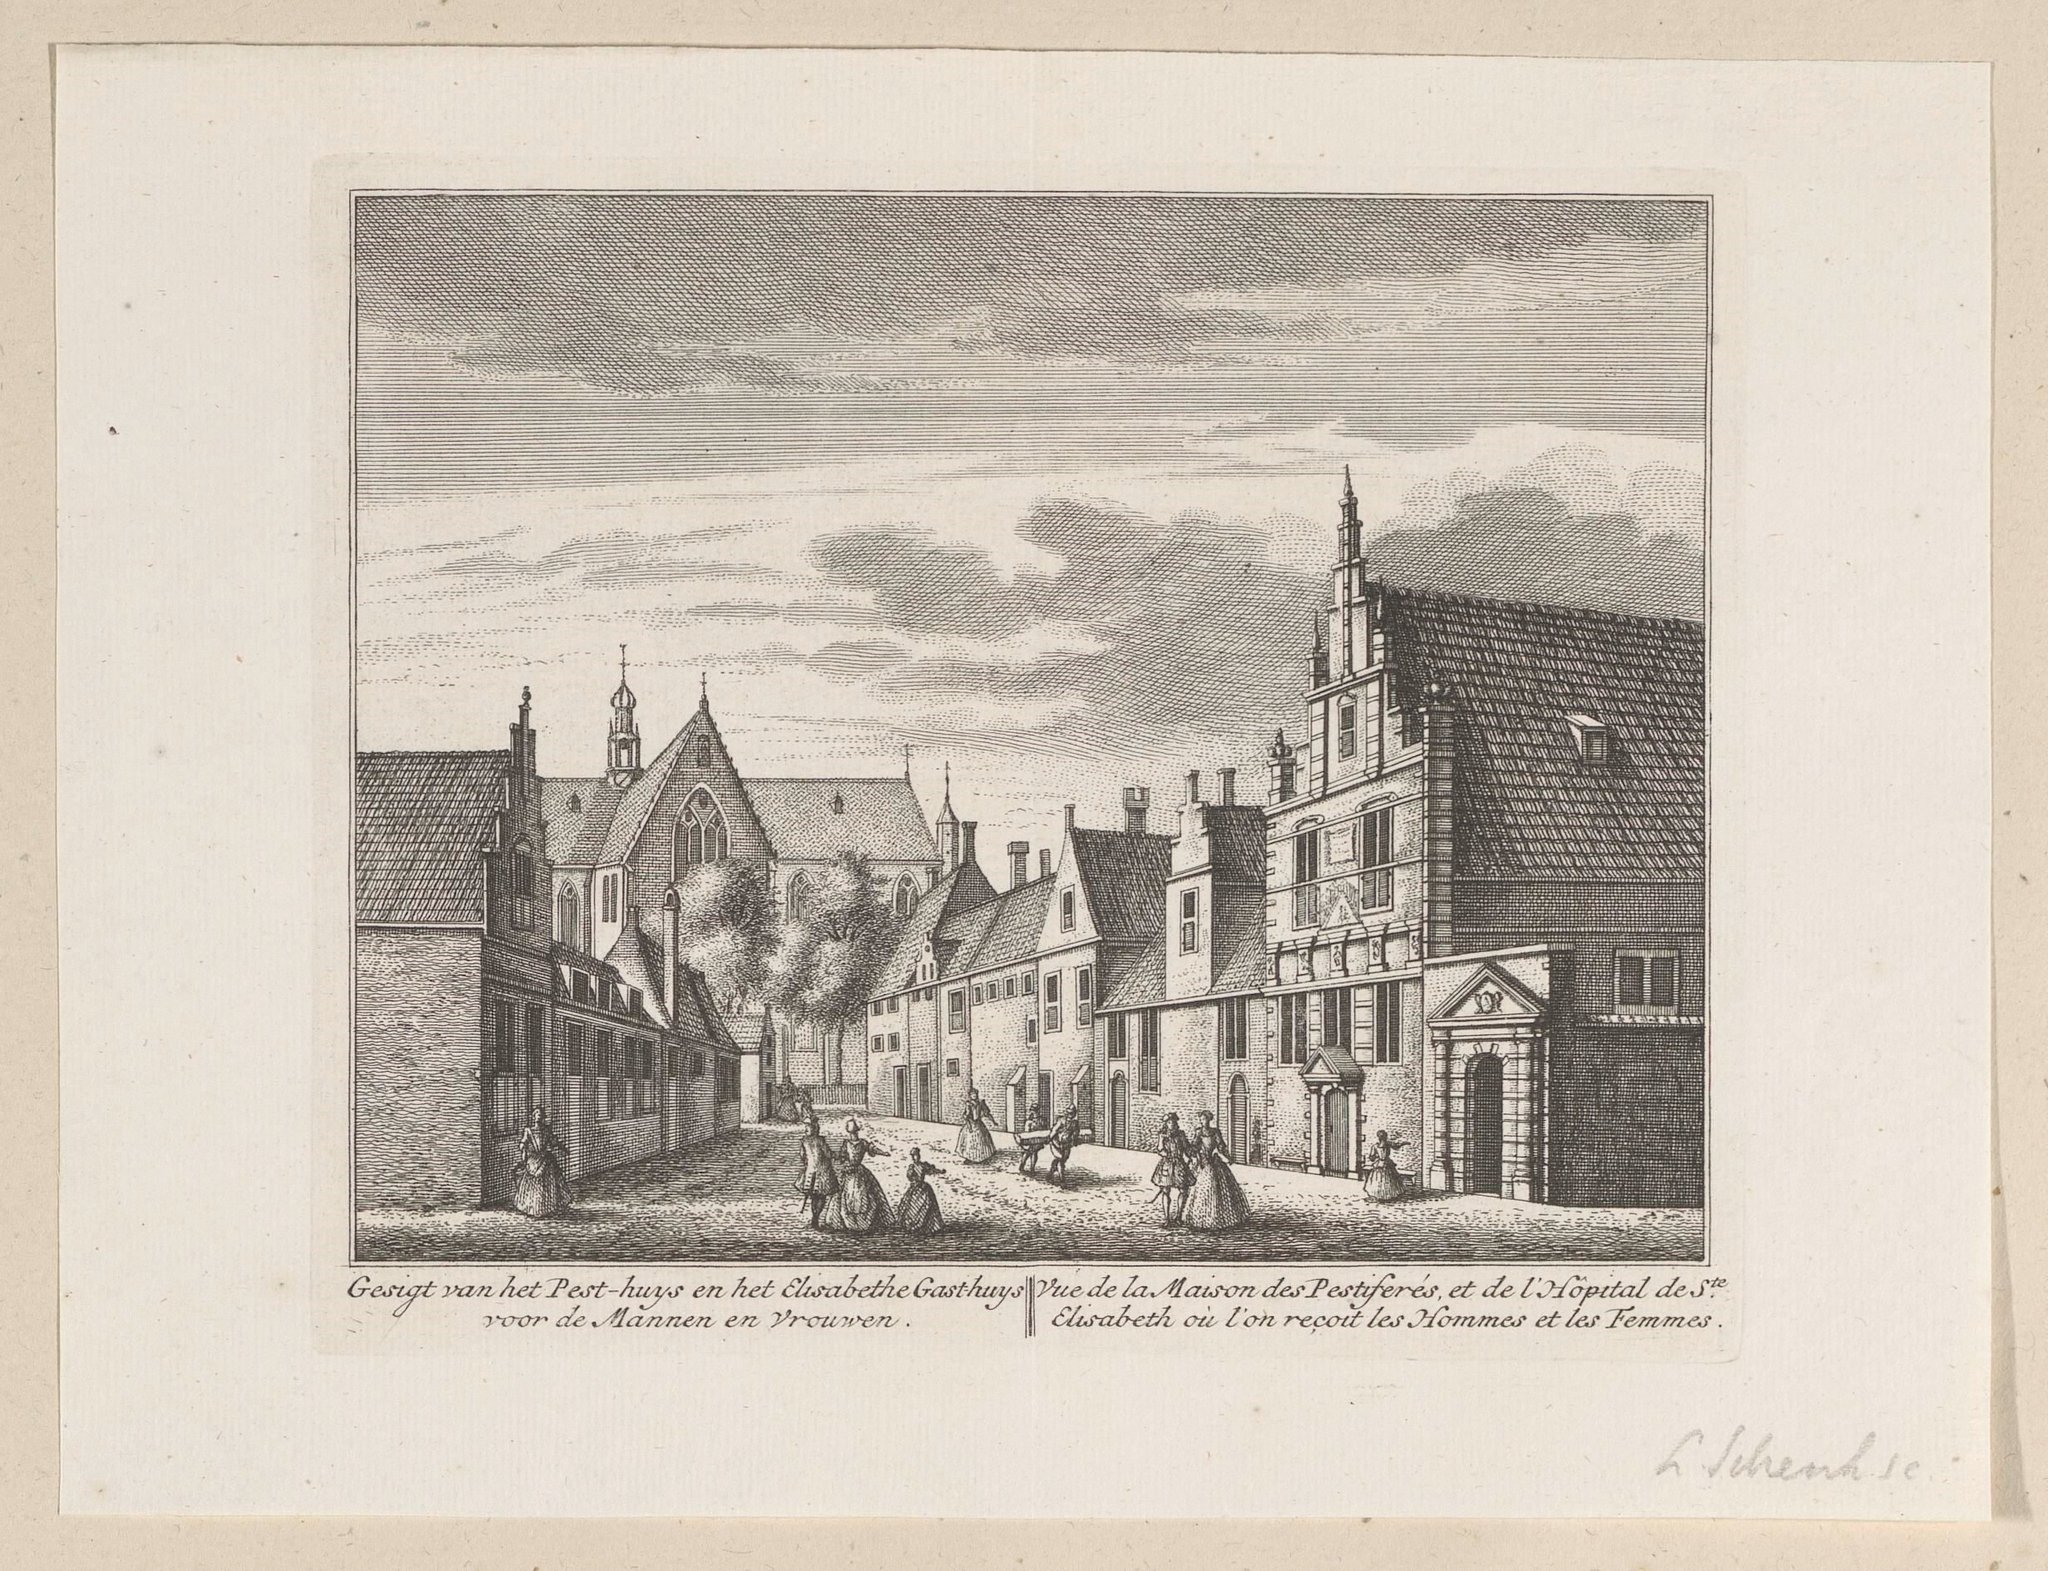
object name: print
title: Alle de voornaamste gesigten van de stadt Alckmaar geleegen in West-Vriesland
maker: leonard schenk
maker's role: print maker, publisher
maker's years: 1696-1767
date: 1736-1746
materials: paper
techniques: etching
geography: amsterdam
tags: hospital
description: Als onderdeel van een prentserie van gezichten op Alkmaar in een publicatie met drie prentseries van stadsgezichten (op Alkmaar, Delft en Dordrecht) is deze prent ook gebruikt in: Rademaker, Abraham. Alle de voornaamste gesigten van de wydberoemde steeden Alkmaar, Delft en Dordregt (...) / Toutes les principales vuës de la fameuse villes d'Alcmar, Delft & Dordregt (…). Amsterdam: Leonard Schenk, 1736. Als illustratie is deze prent ook gebruikt in: Woude, C. van der. Kronyck van Alckmaar. Met zyn dorpen (…). 2e druk. Amsterdam: Steven van Esveldt, 1743. En in: Woude, C. van der. Kronyck van Alckmaar. Met zyn dorpen (…). 2e druk. Den Haag: Johannes de Cros, 1746. Uit welke druk het huidige exemplaar precies komt is niet na te gaan.